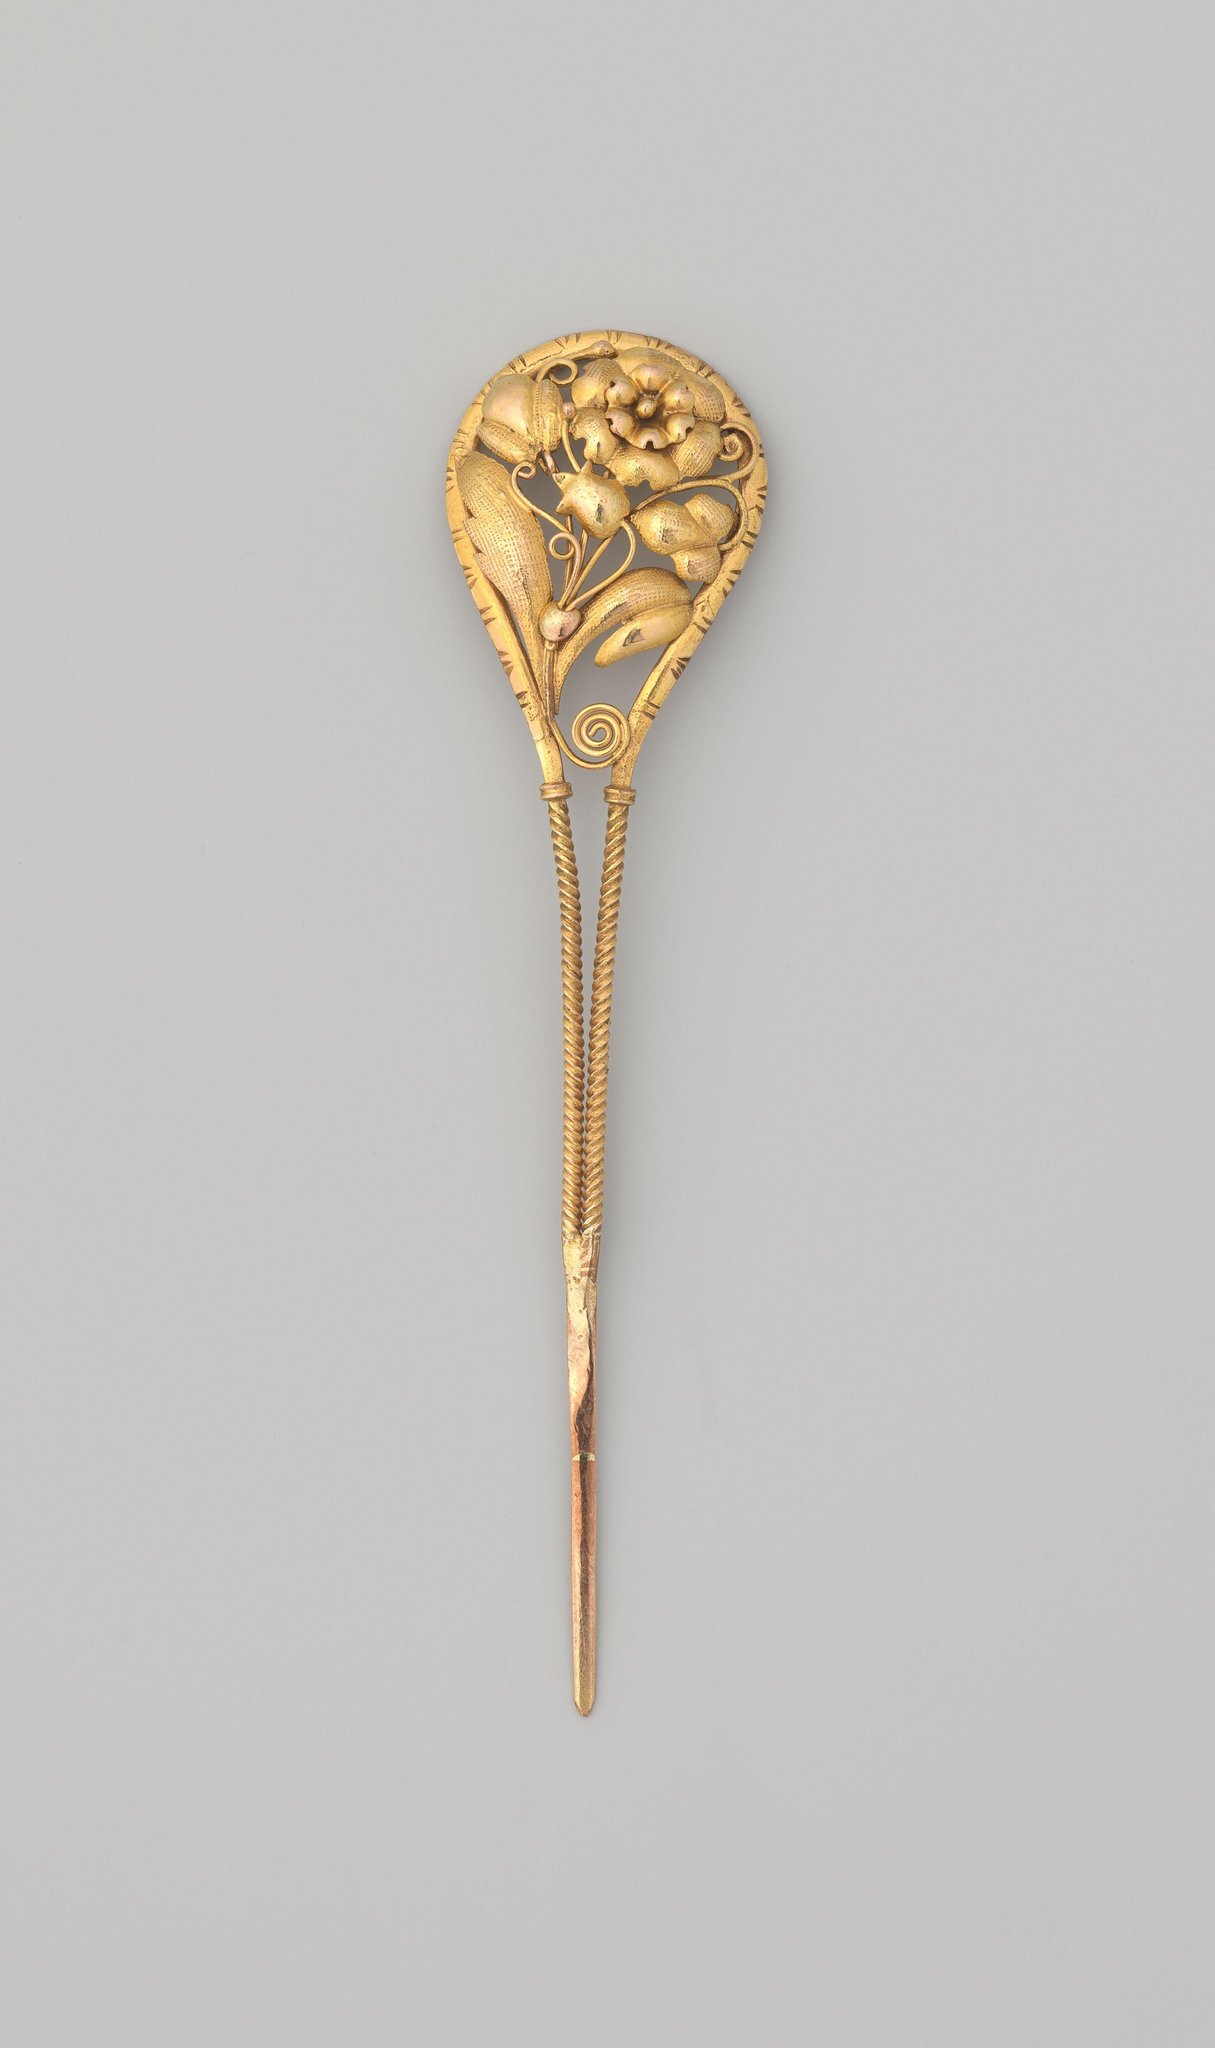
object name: hairpin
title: Haarspeld van goud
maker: Anonymous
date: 1950-1960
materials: gold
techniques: manufacturing, gilding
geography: indonesia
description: Haarspeld van goud met florale motieven. Het onderstuk is eraan gesoldeerd en is vermoedelijk niet origineel. De speld is naverguld.